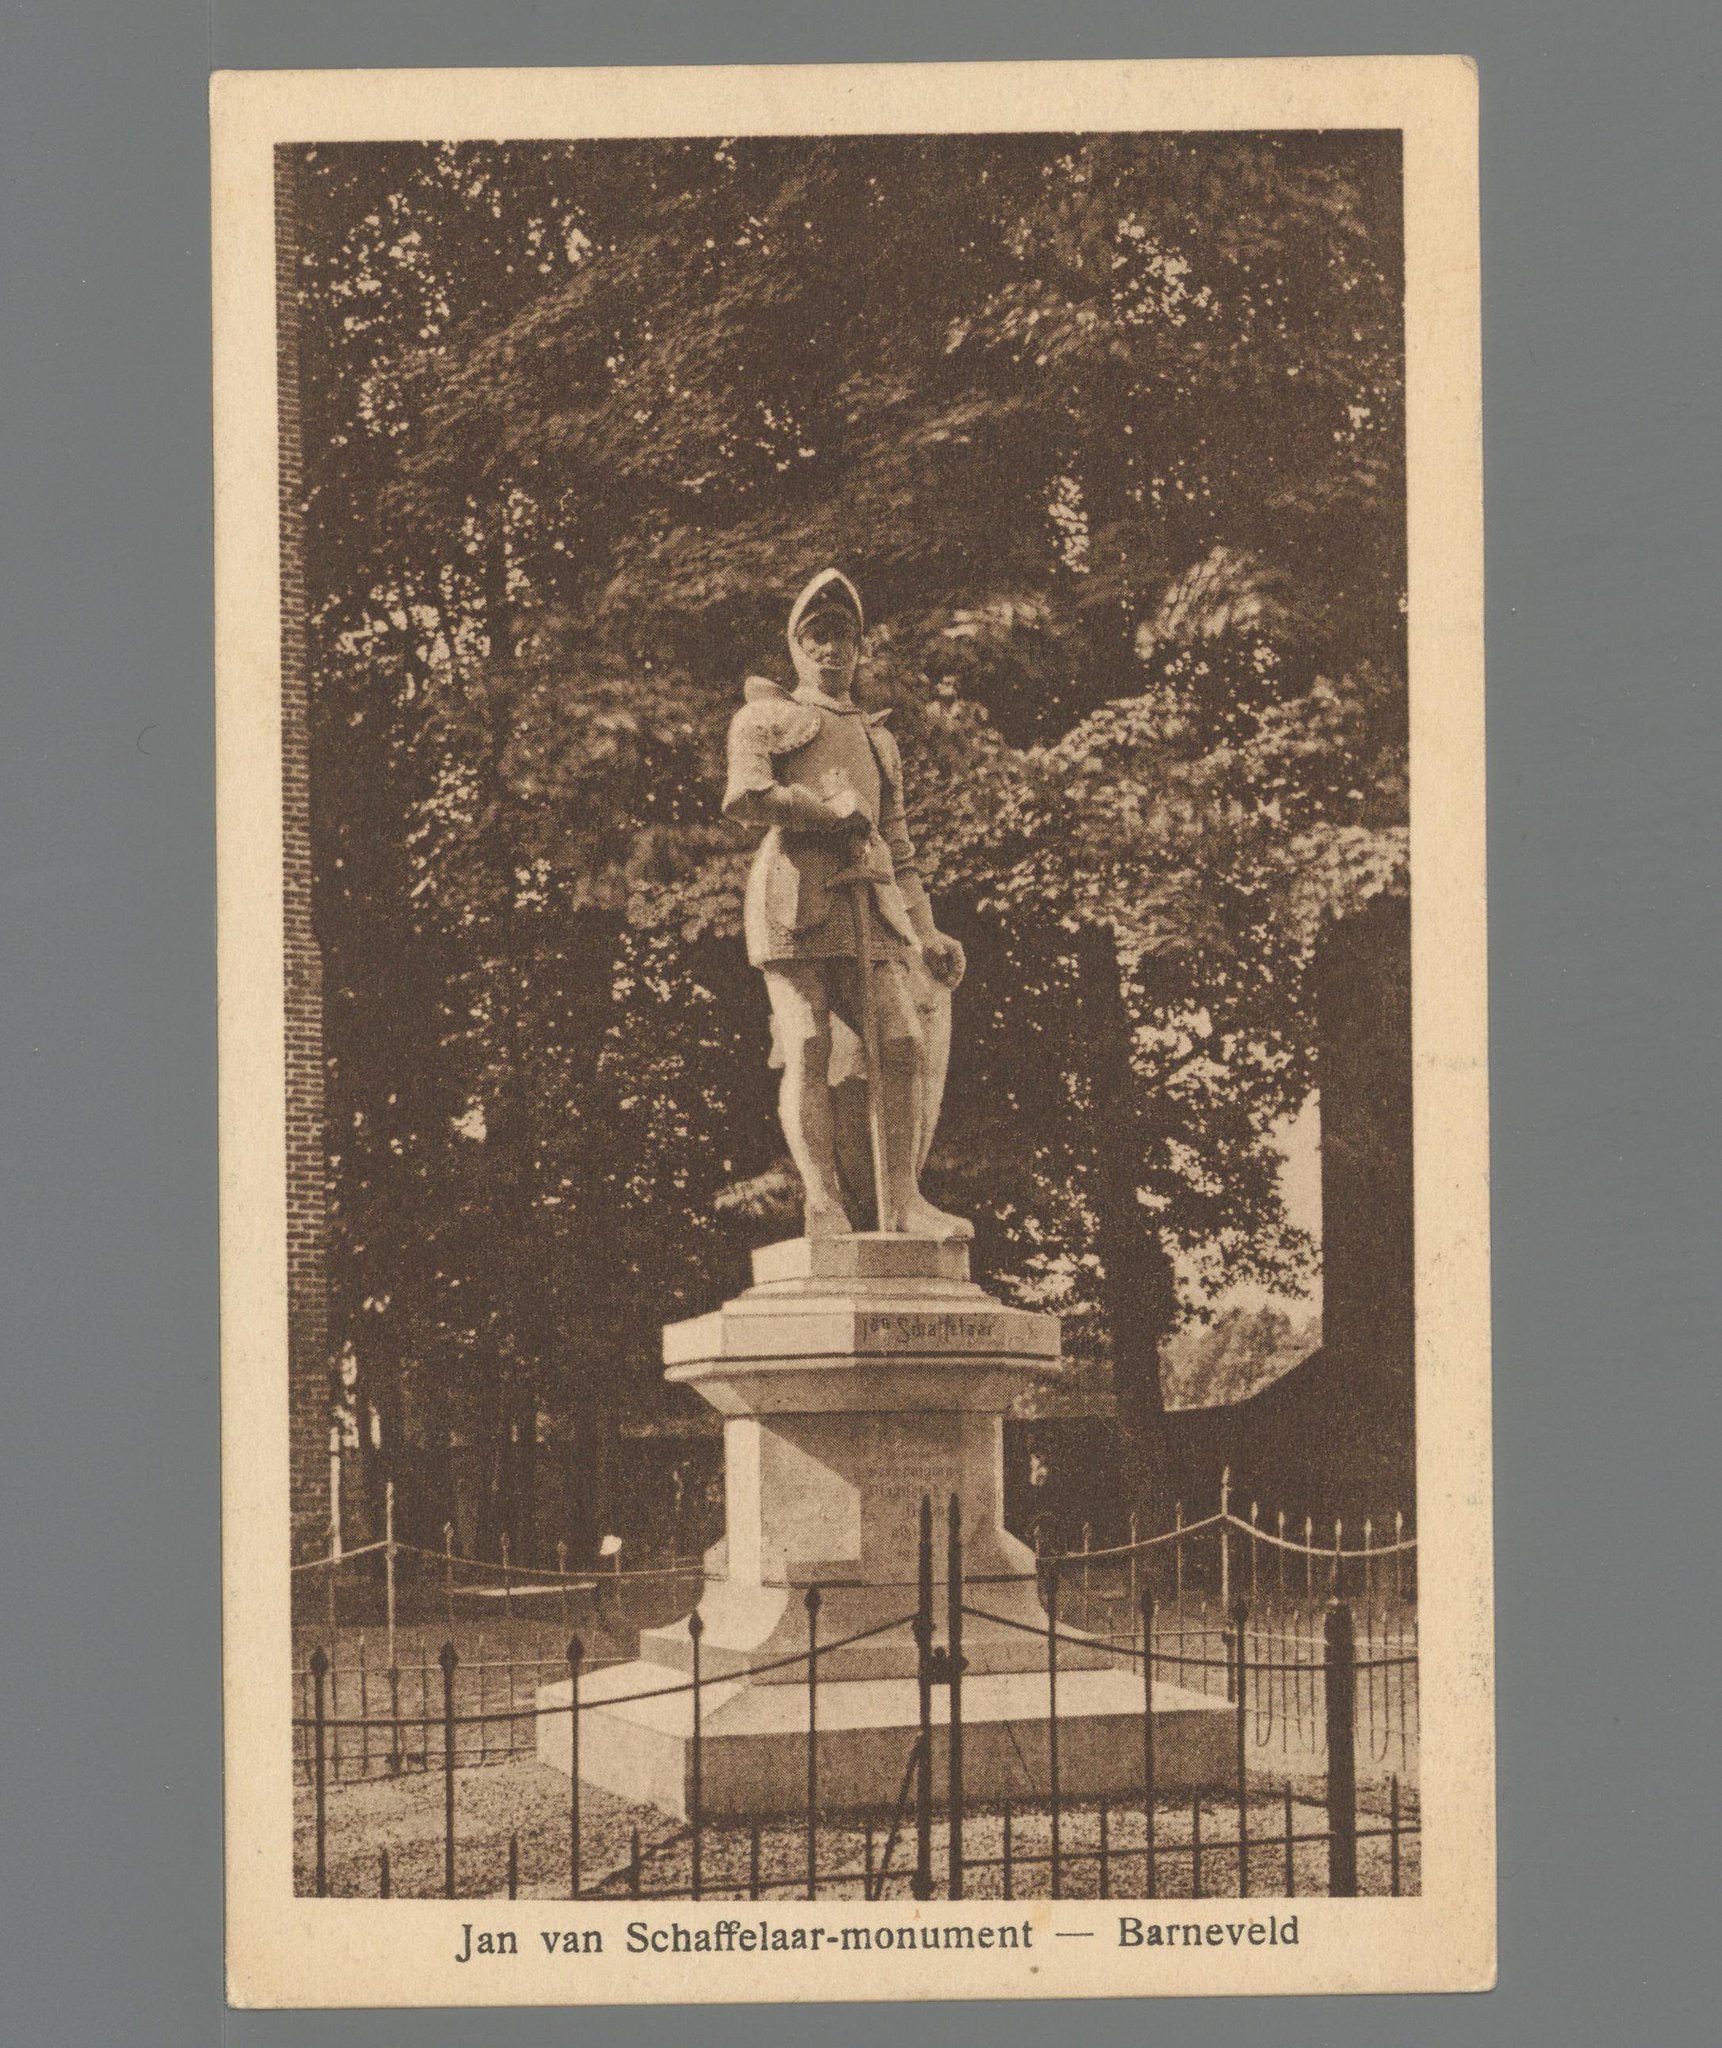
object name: ansichtkaart, prentbriefkaart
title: Jan van Schaffelaar-monument - Barneveld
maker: Anonymous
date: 1913-1923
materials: cardboard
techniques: photograph, writing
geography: barneveld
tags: fence, wall, paling, monument, statue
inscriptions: postage stamp